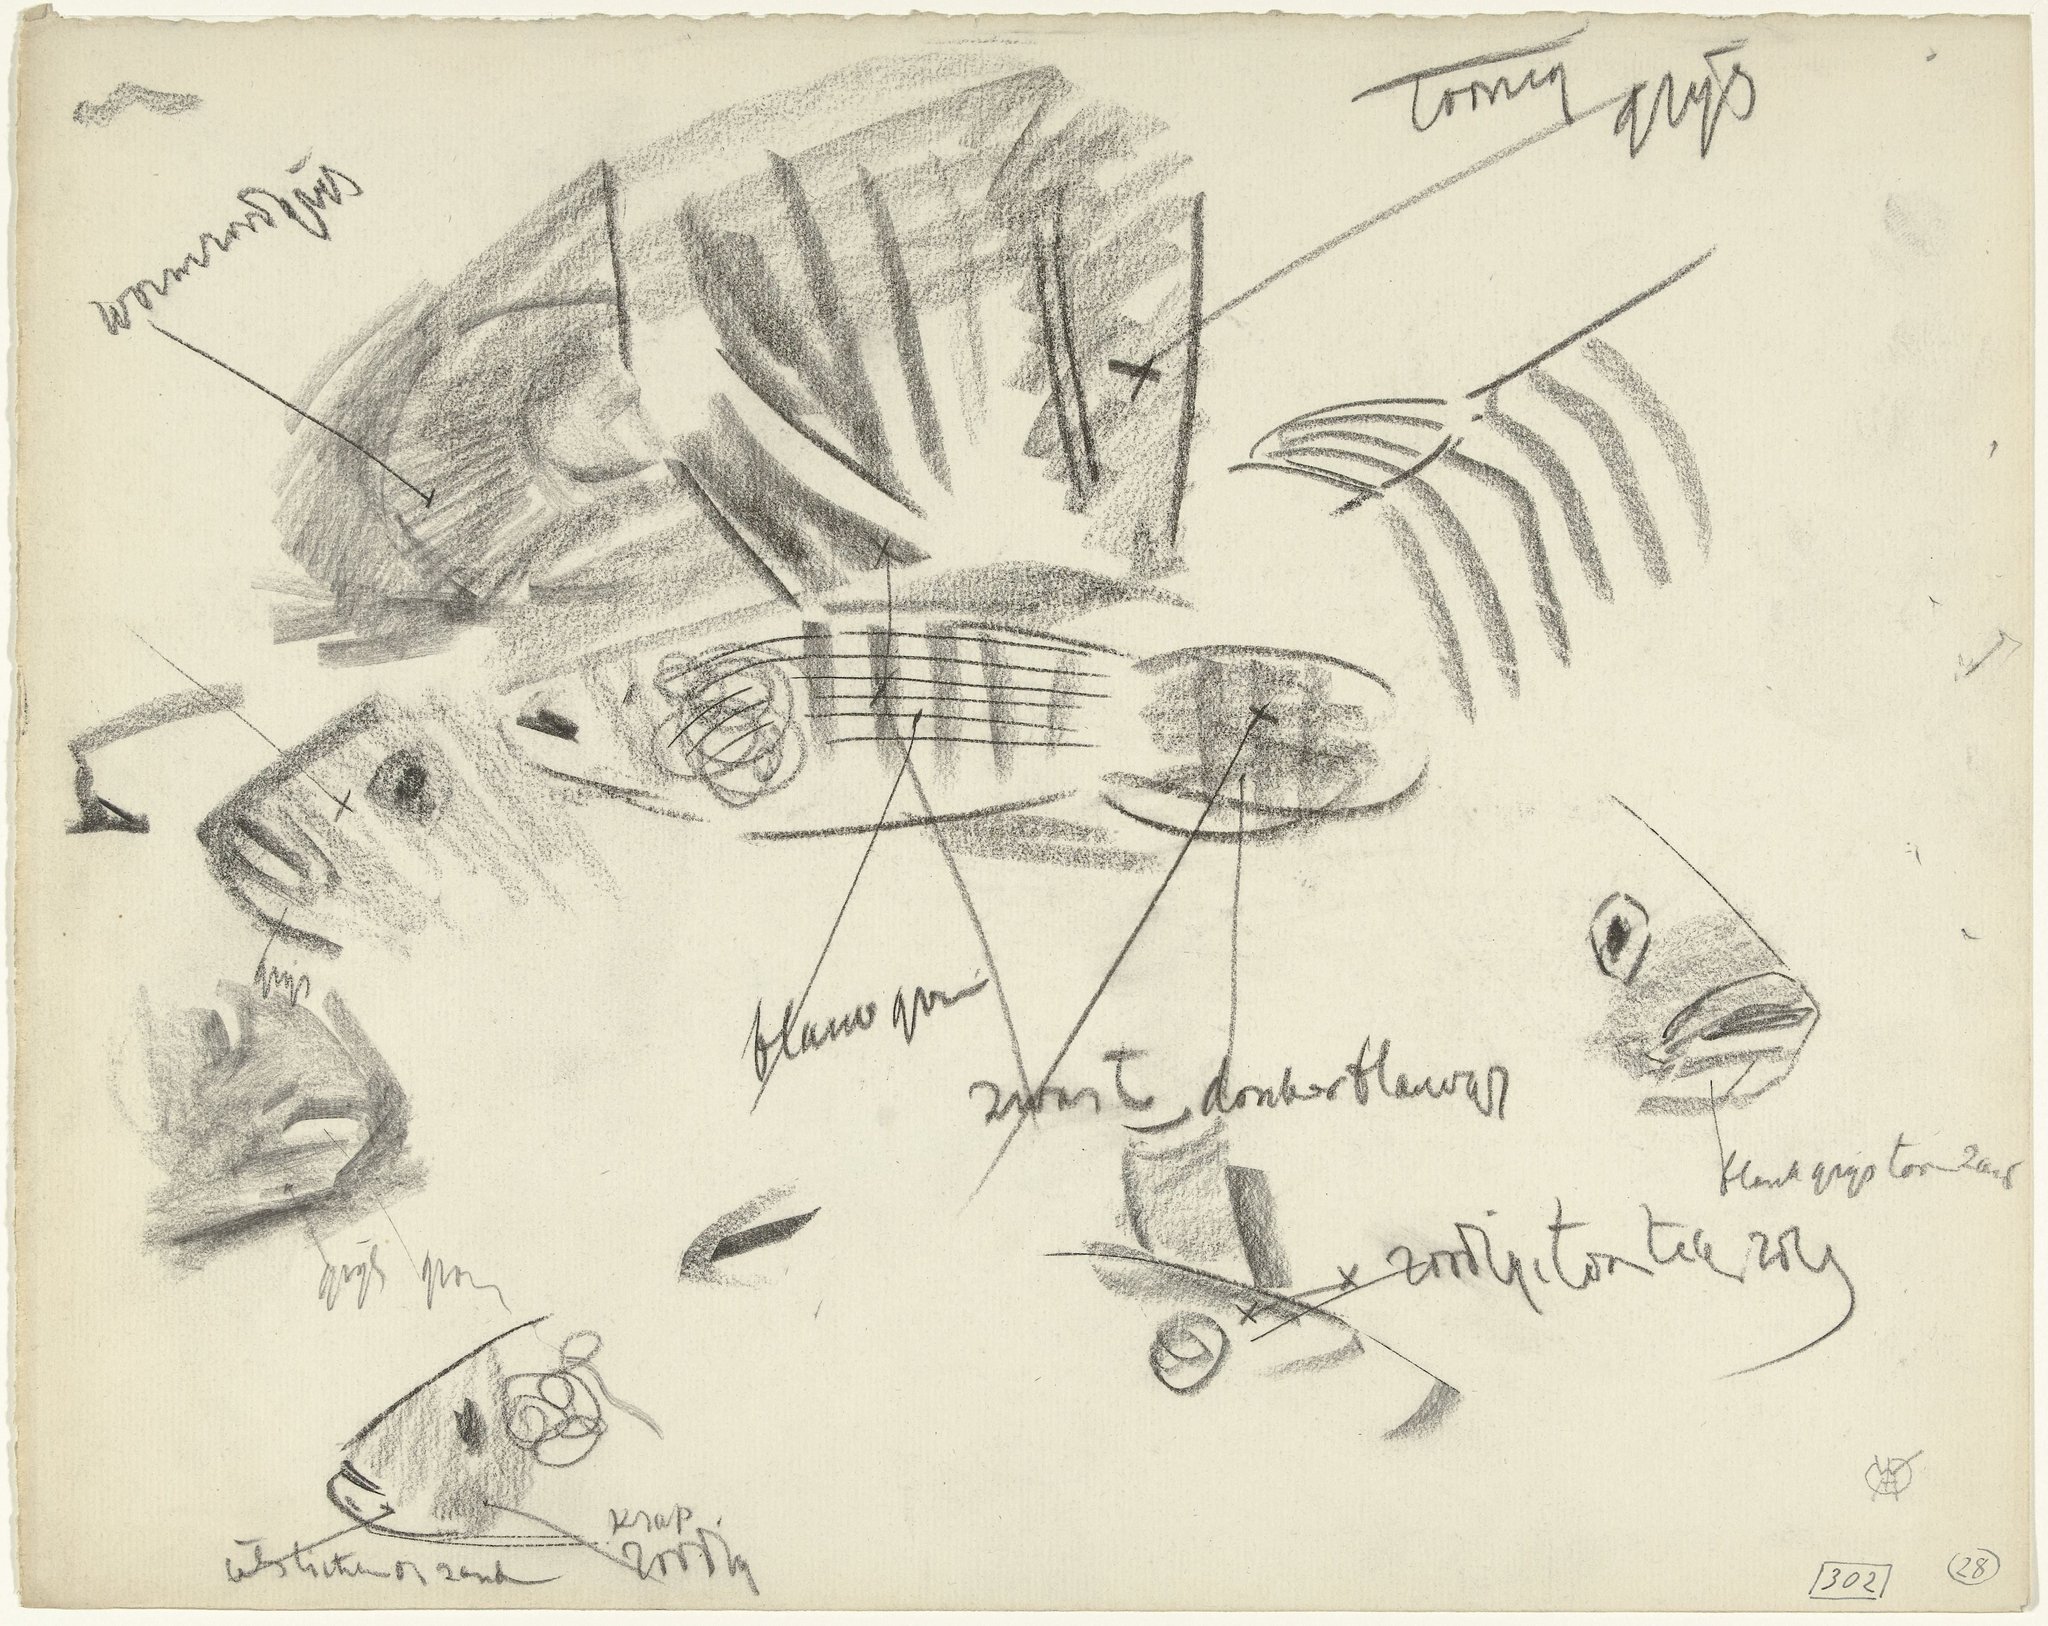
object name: drawing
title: Detailstudies van vissen, met kleurnotities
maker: gerrit willem dijsselhof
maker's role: designer, draughtsman, print maker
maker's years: 1866-1924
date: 1876-1924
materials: chalk, paper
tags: bony fishes